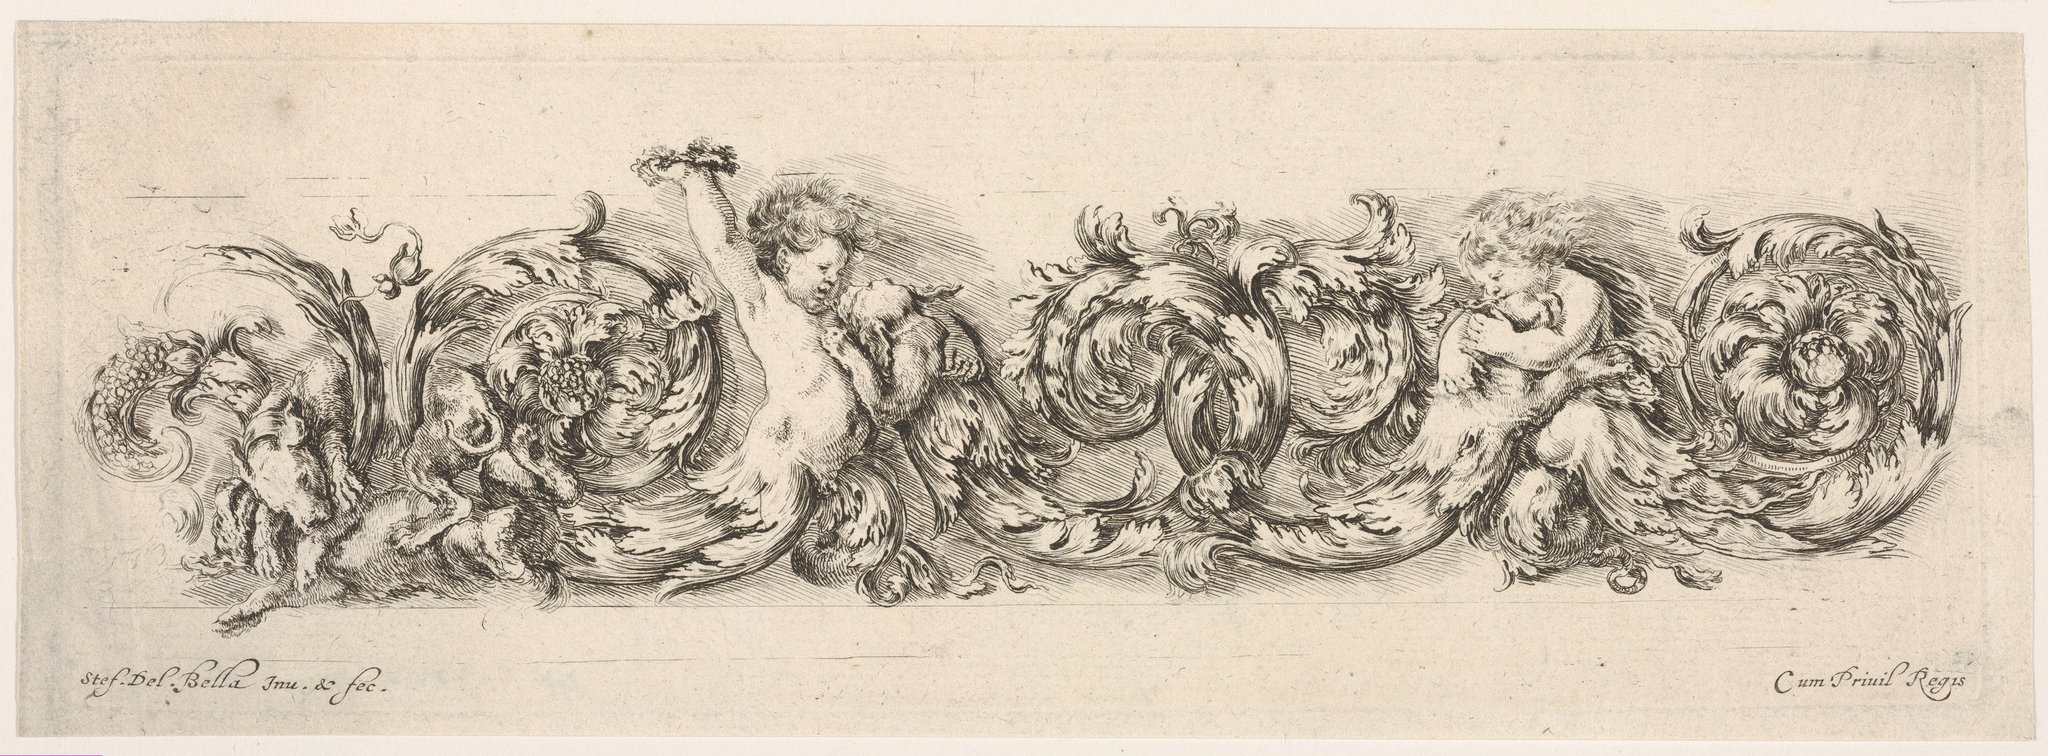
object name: print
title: Design for a Frieze with Acanthus Scrolls and Playing Putti and Dogs, plate 12 from "Decorative friezes and foliage" (Ornamenti di fregi e fogliami)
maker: stefano della bella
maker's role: artist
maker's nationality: italian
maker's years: 1610-1664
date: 1645-1650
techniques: etching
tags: putti,dogs,acanthus